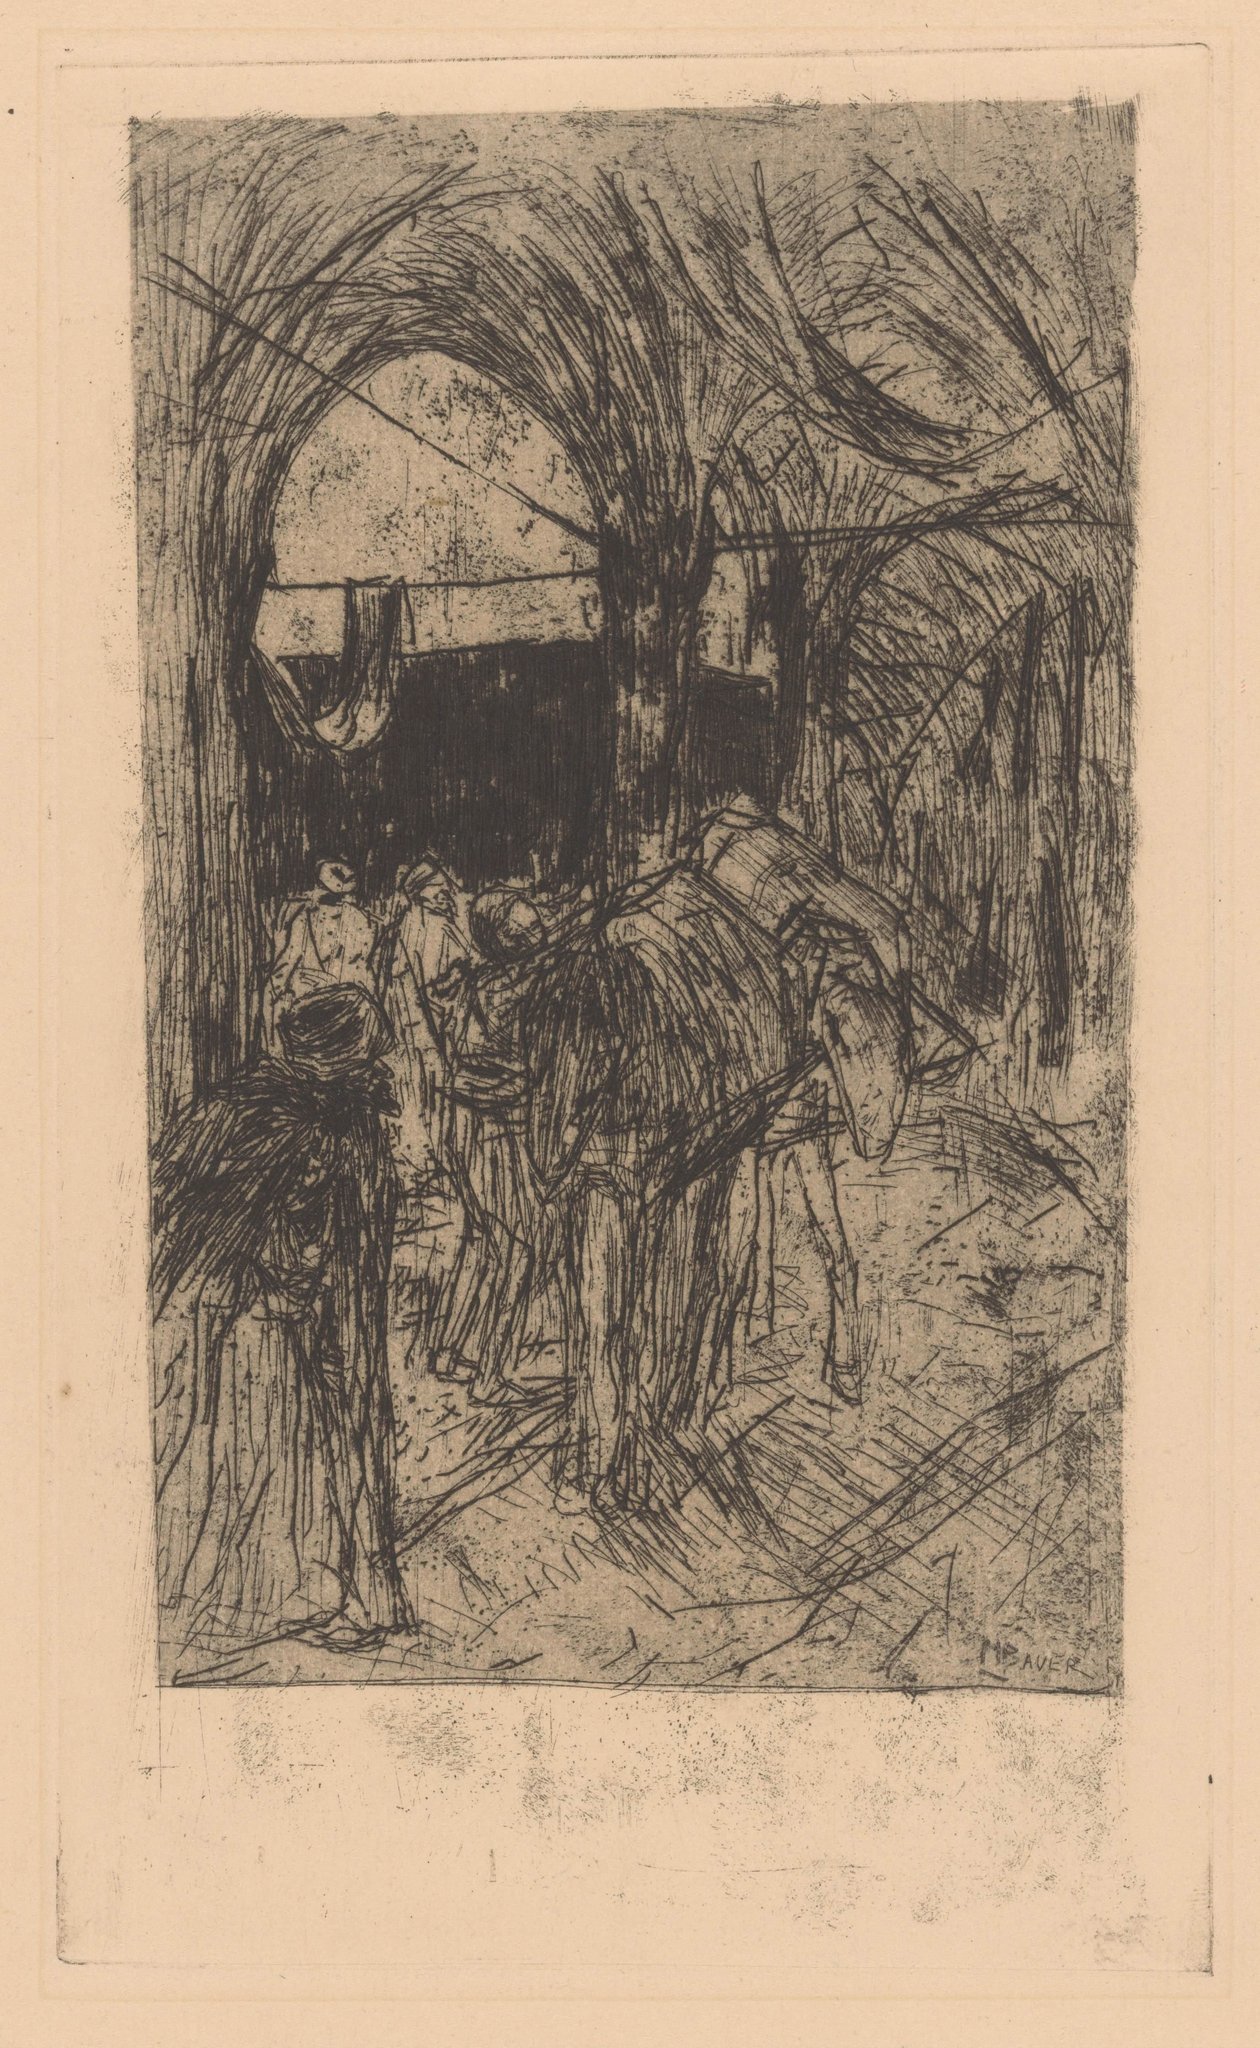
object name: print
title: Pakpaarden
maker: marius bauer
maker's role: draughtsman, print maker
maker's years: 1867-1932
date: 1889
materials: paper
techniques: etching, intaglio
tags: pack-animal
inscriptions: collector's mark: Lugt 2228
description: Verschillende figuren bij twee met vracht beladen paarden.